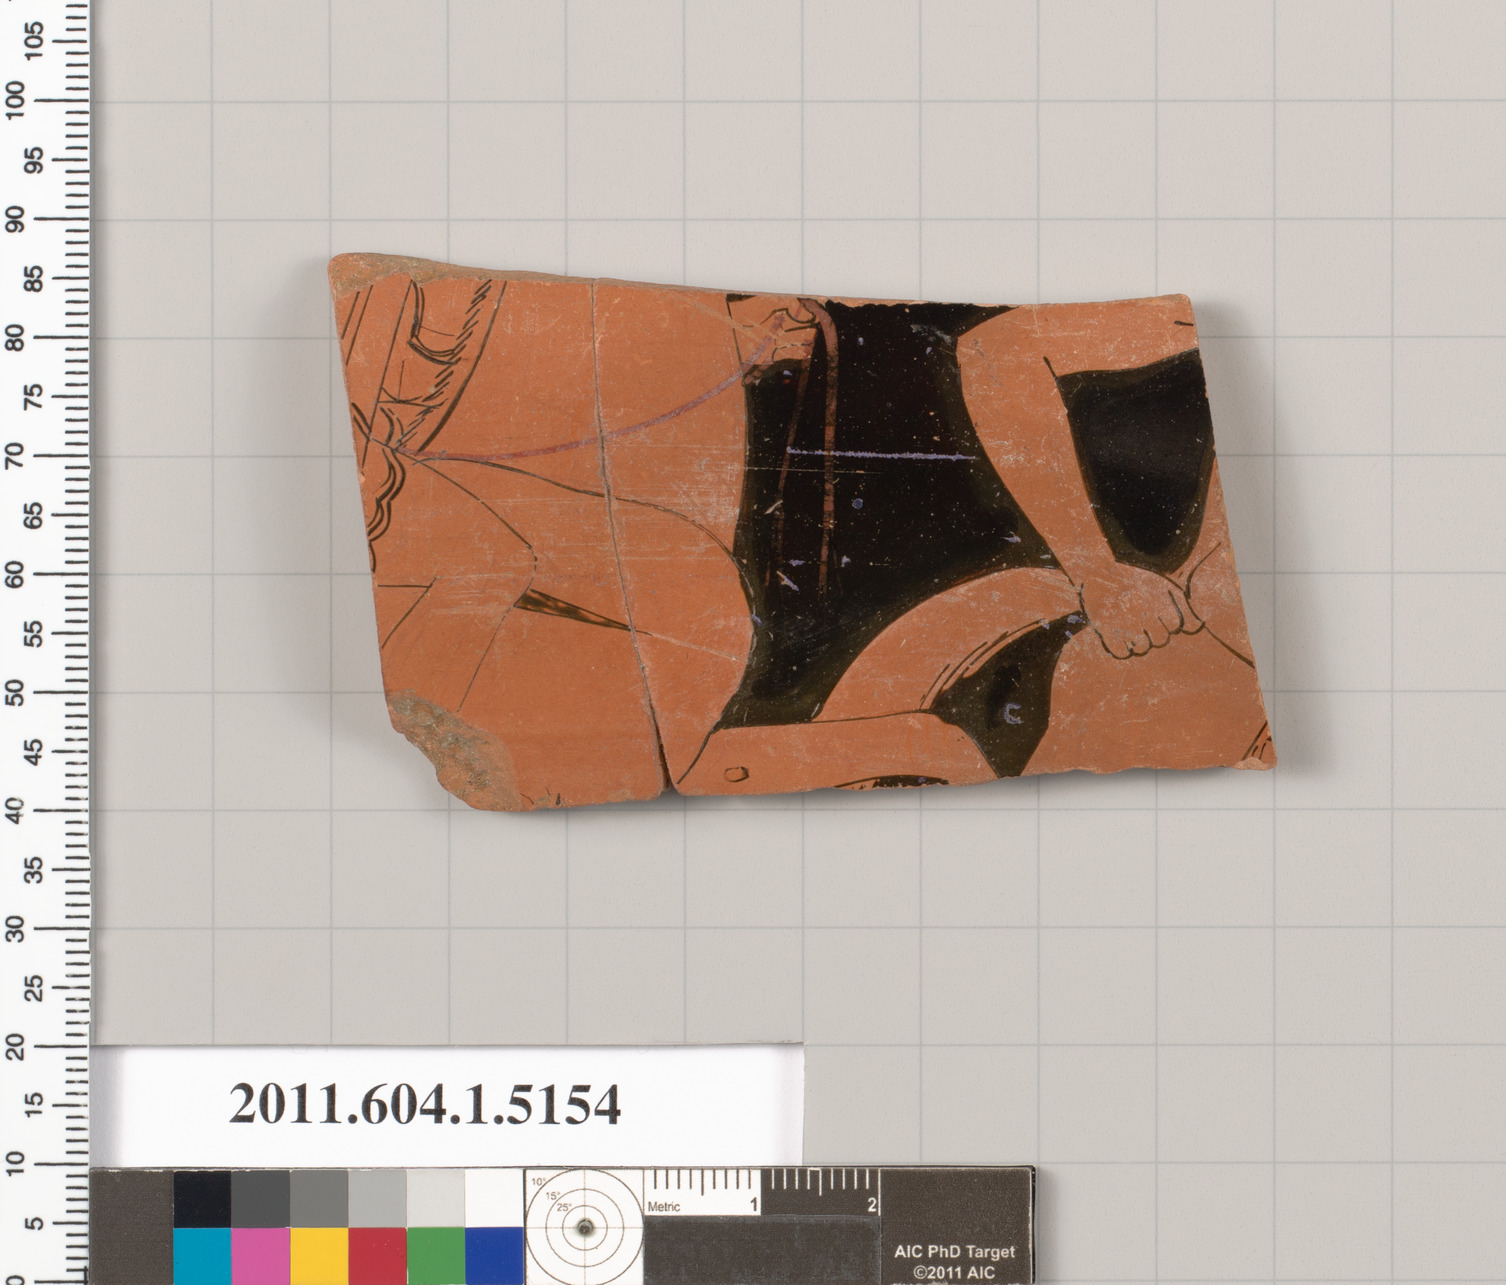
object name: kylix fragment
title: Terracotta fragment of a kylix (drinking cup)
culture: greek, attic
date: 500-480 BCE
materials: terracotta